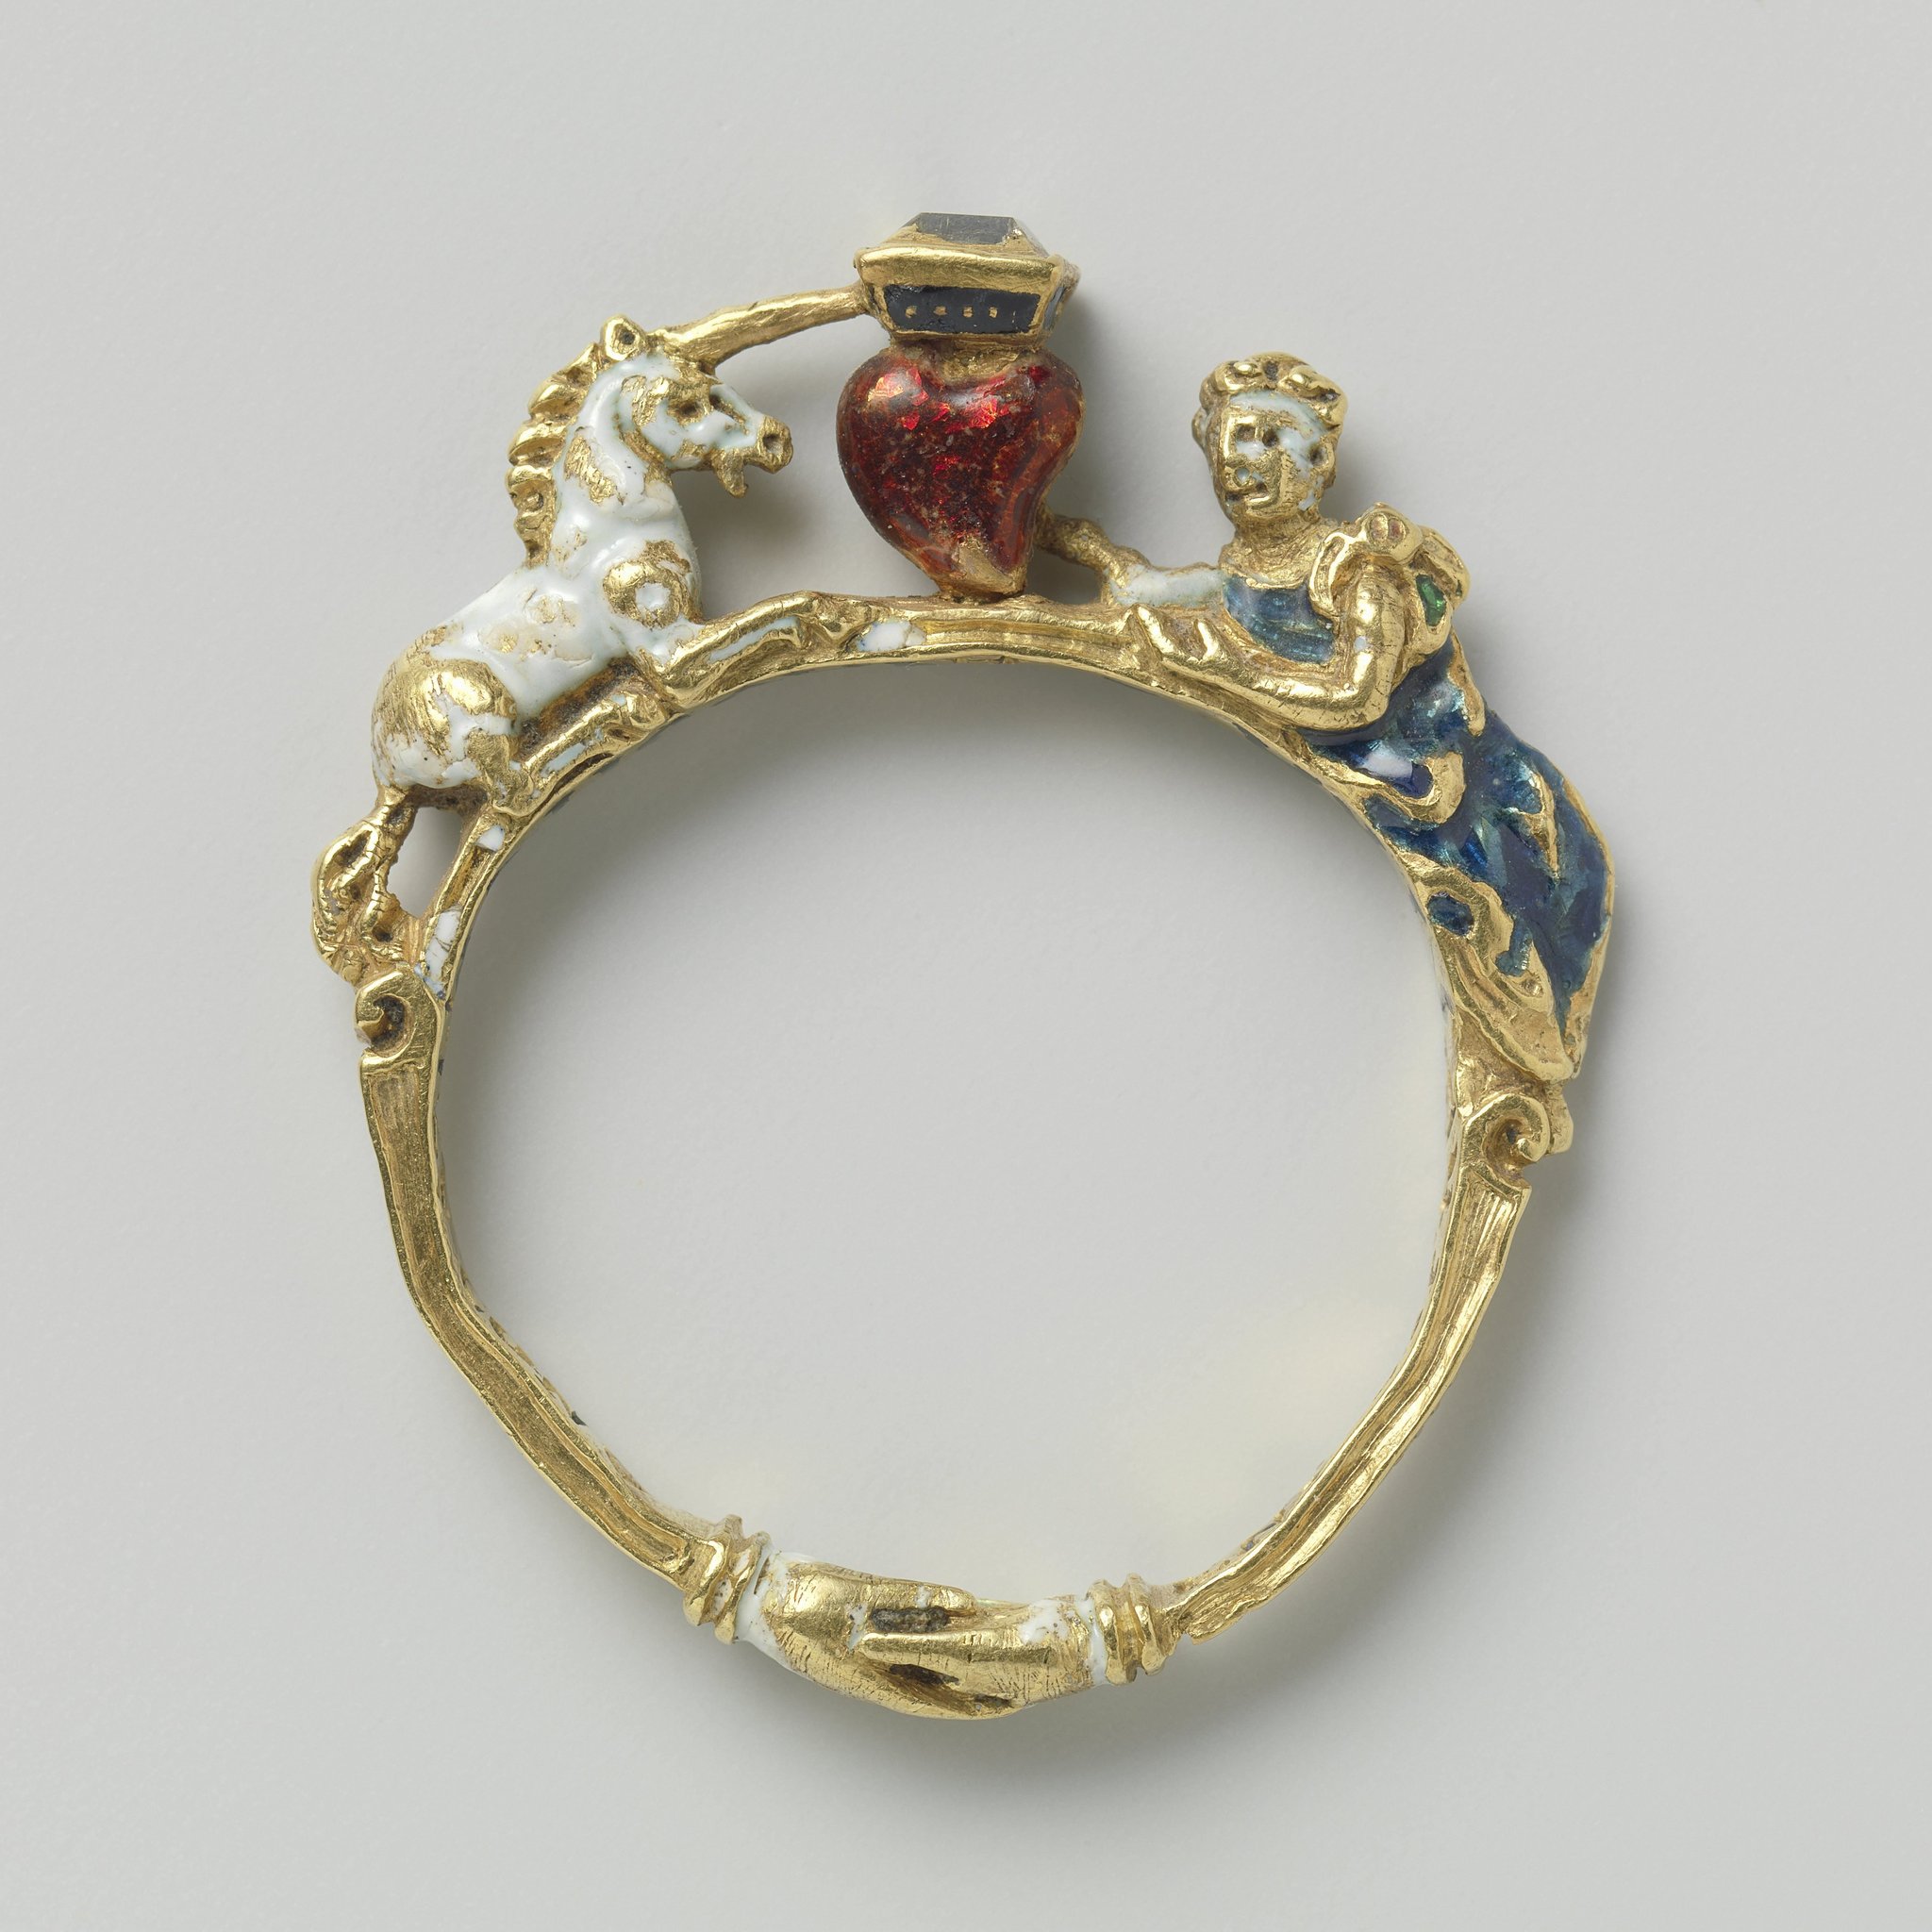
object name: jewellery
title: Ring met dame met de eenhoorn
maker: Anonymous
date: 1550-1600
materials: diamond, gold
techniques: enameling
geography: southern germany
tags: unicorn, shaking hands, 'dextrarum junctio'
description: Ring, unicorn. Gold and enamel. Southern Germany or Italy, c. 1550-1600.